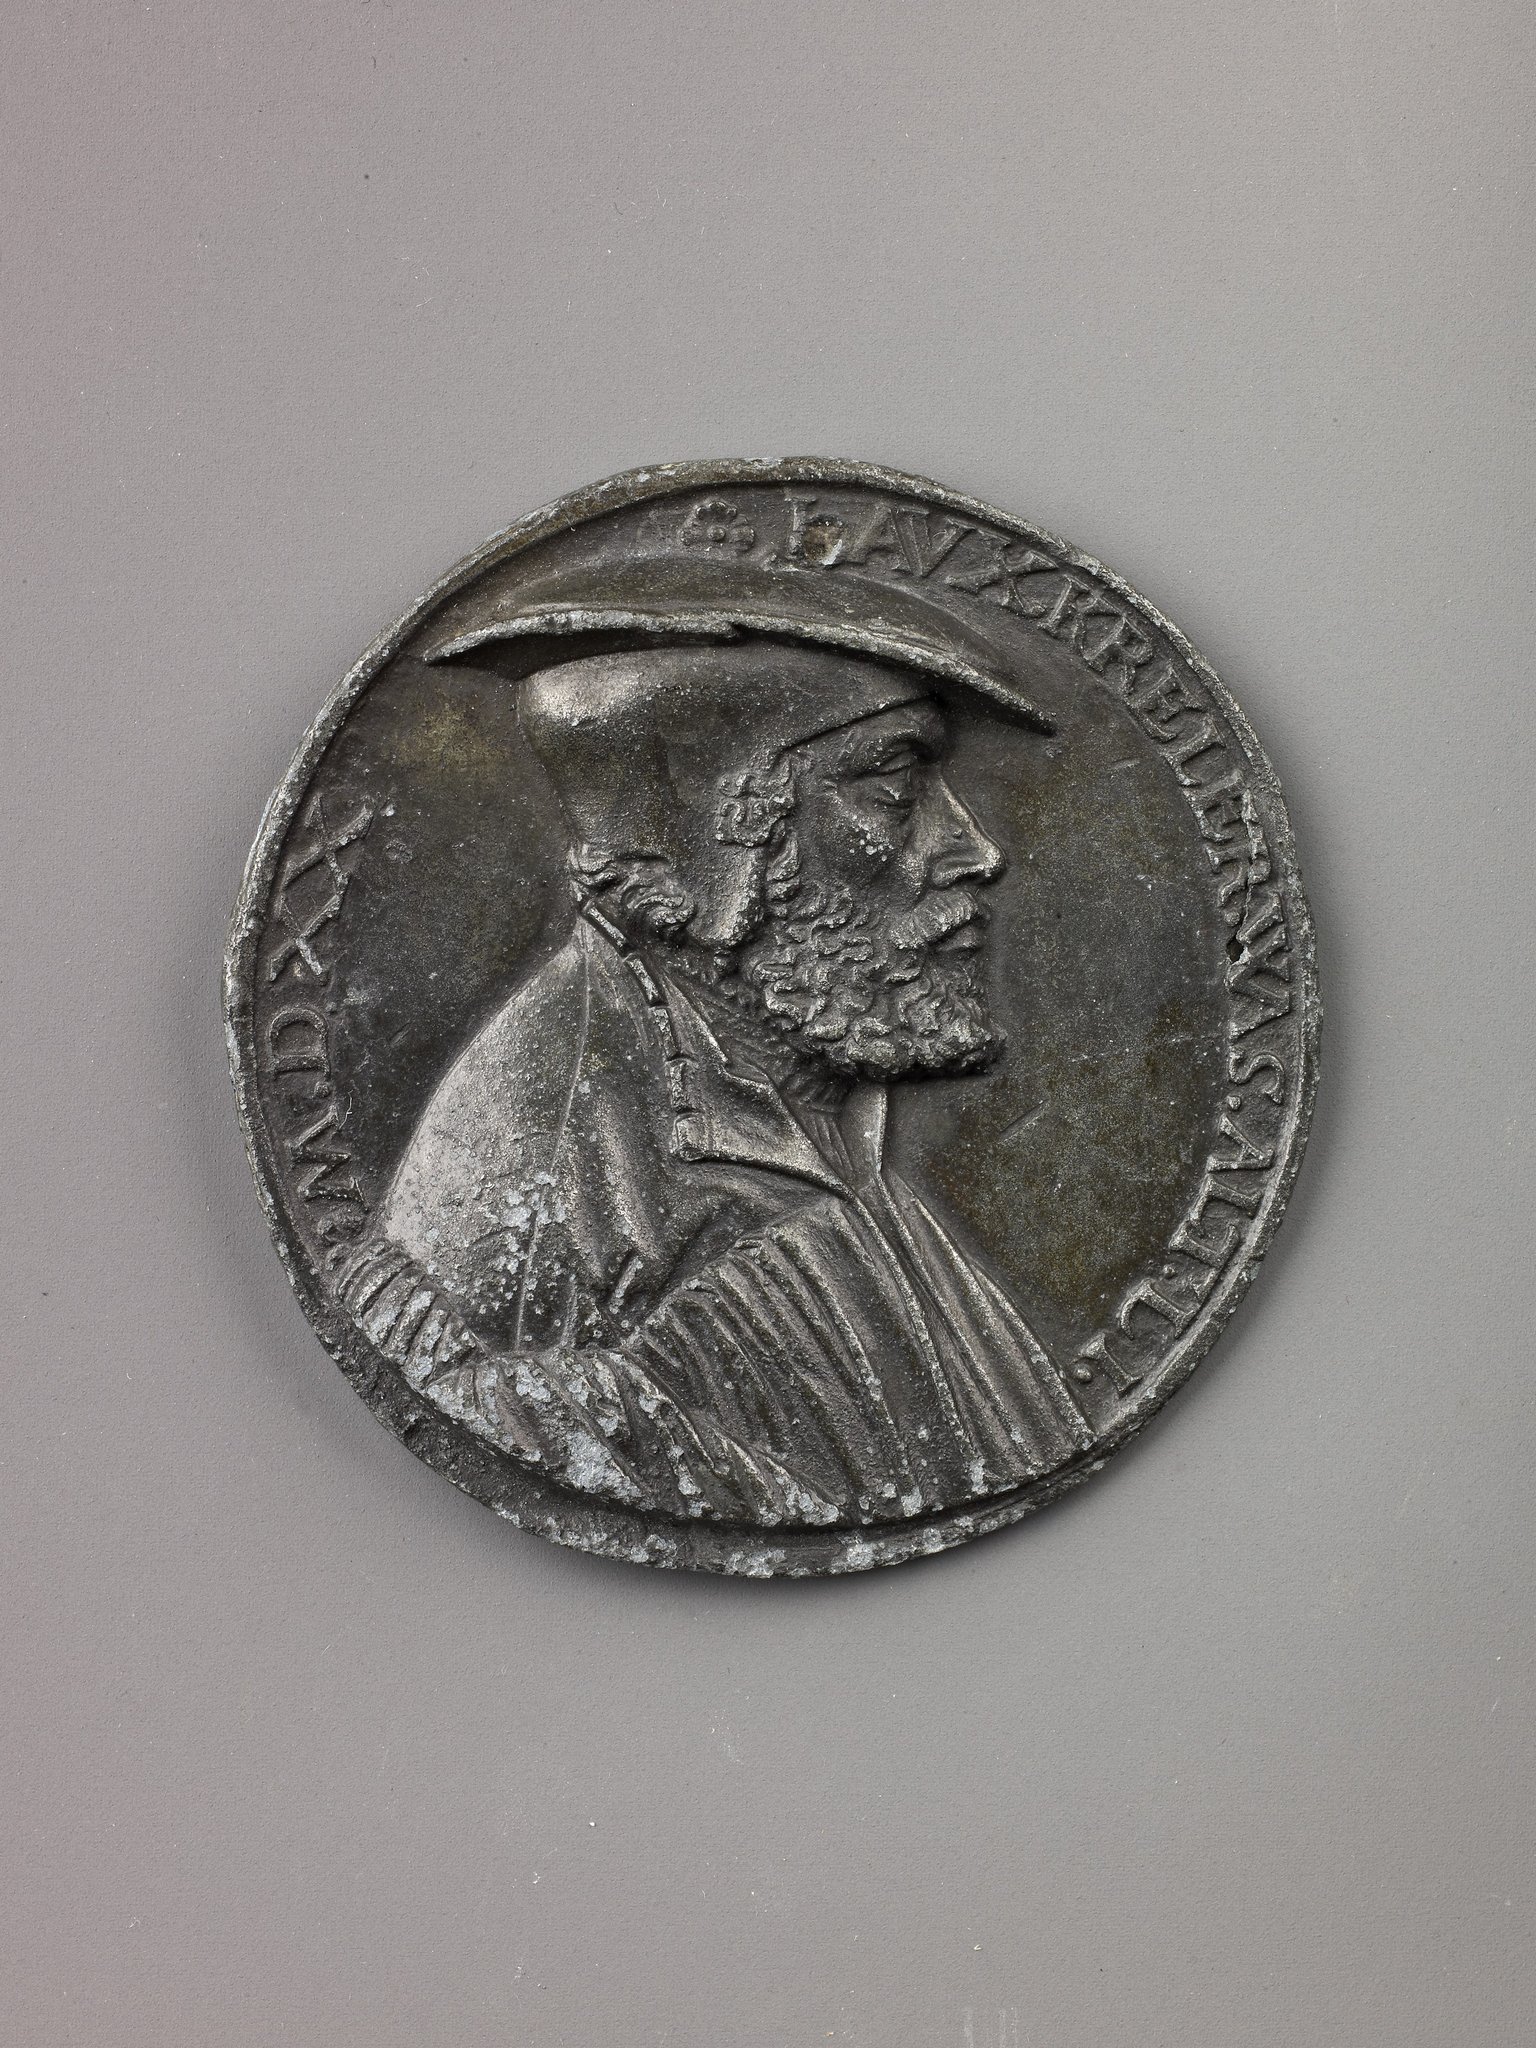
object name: medal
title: Portrait medal of Laux Kreler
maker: german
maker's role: artist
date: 1537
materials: lead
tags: men,portraits,profiles